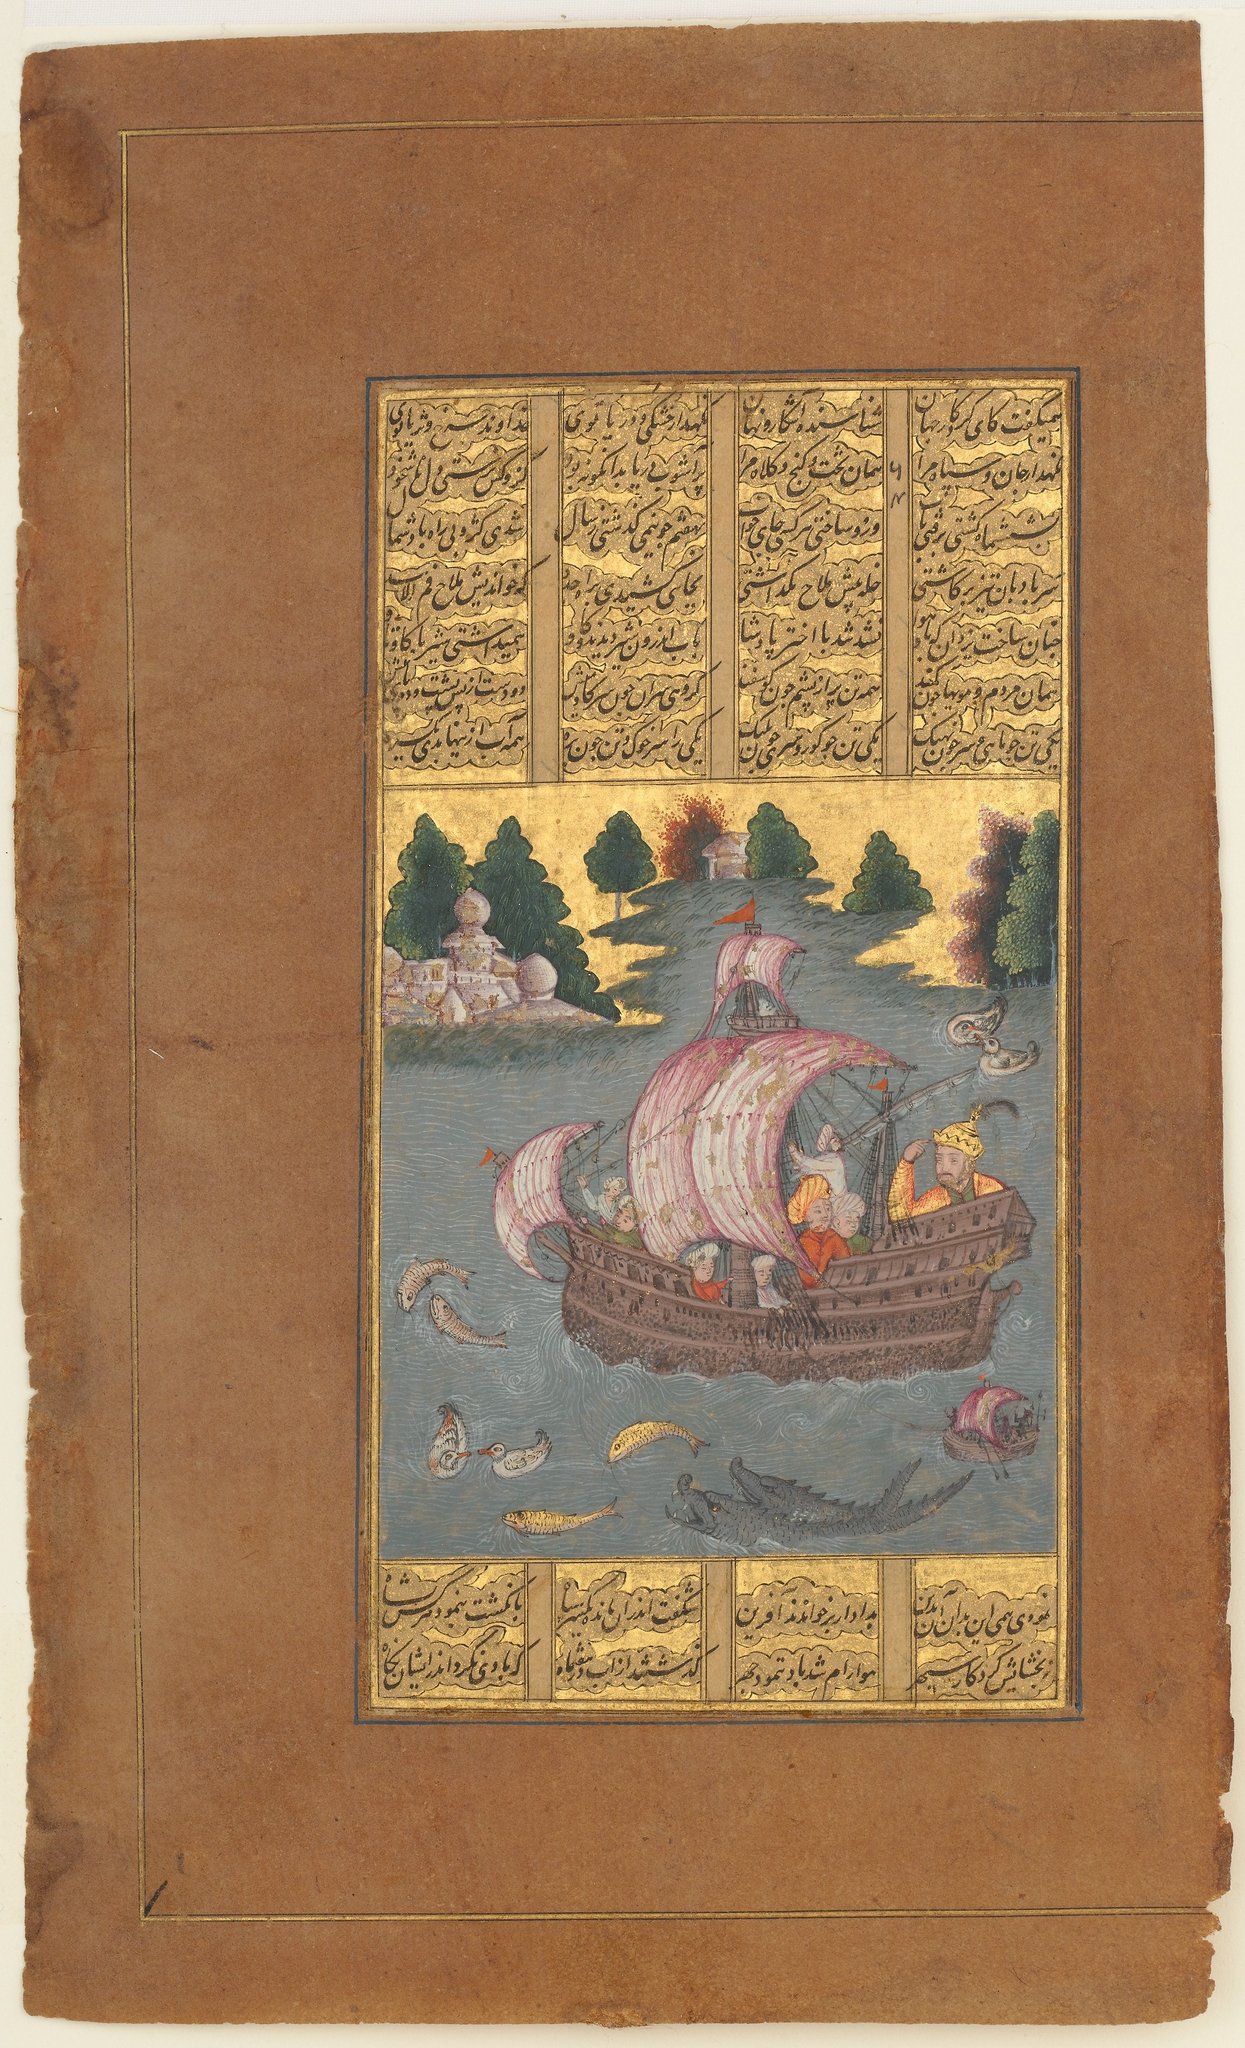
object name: folio from an illustrated manuscript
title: "Kai Khusrau Crosses the Sea", Folio from a Shahnama (Book of Kings) of Firdausi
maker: abu'l qasim firdausi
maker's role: author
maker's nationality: iranian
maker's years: 935-1020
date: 1610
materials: gold, ink, paper, watercolor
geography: india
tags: men,fish,ships